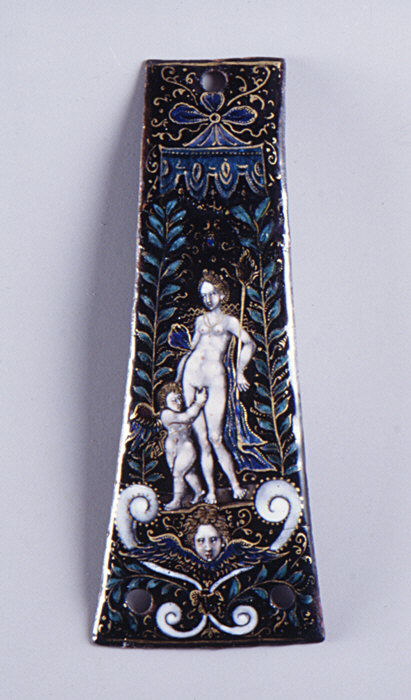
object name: stirrup ornament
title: Venus and Cupid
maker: joseph limosin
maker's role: enameler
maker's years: 1675-1775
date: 1601-1625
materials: copper, enamel, gilt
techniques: painting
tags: cupid,venus